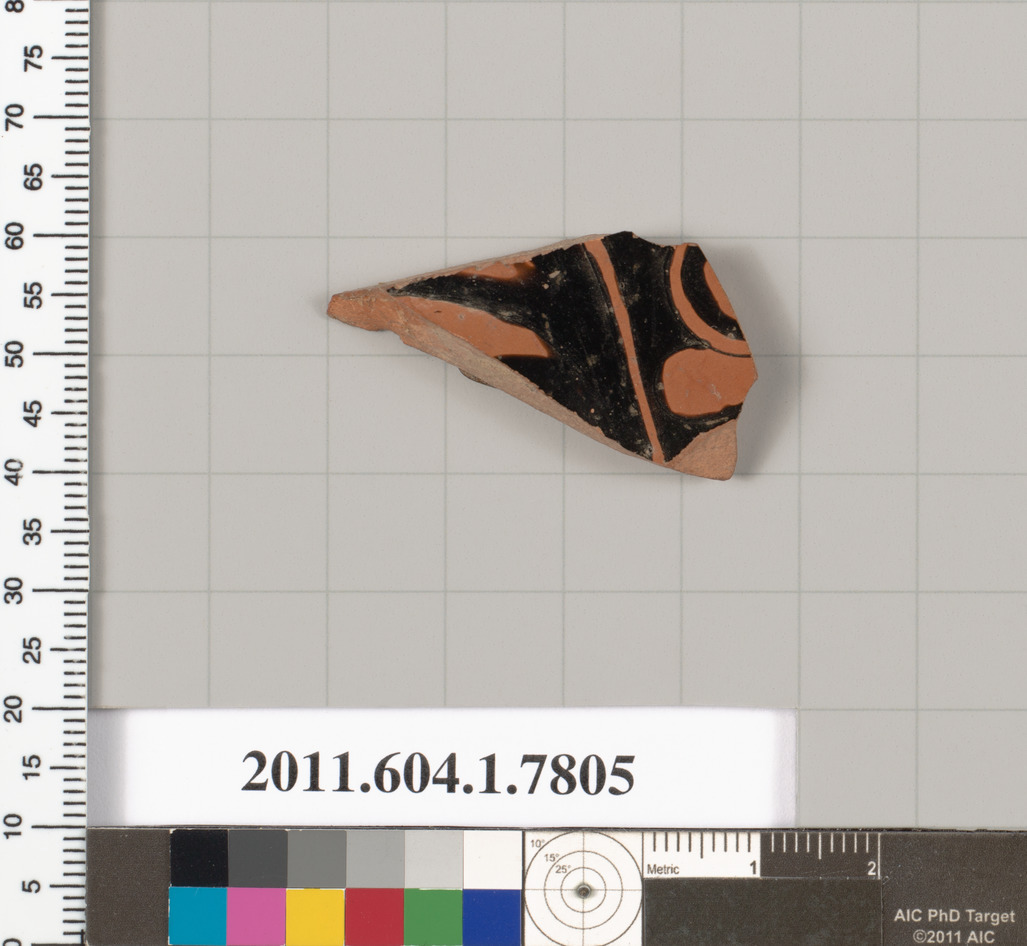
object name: kylix fragment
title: Terracotta fragment of a kylix (drinking cup)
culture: greek, attic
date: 460-450 BCE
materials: terracotta